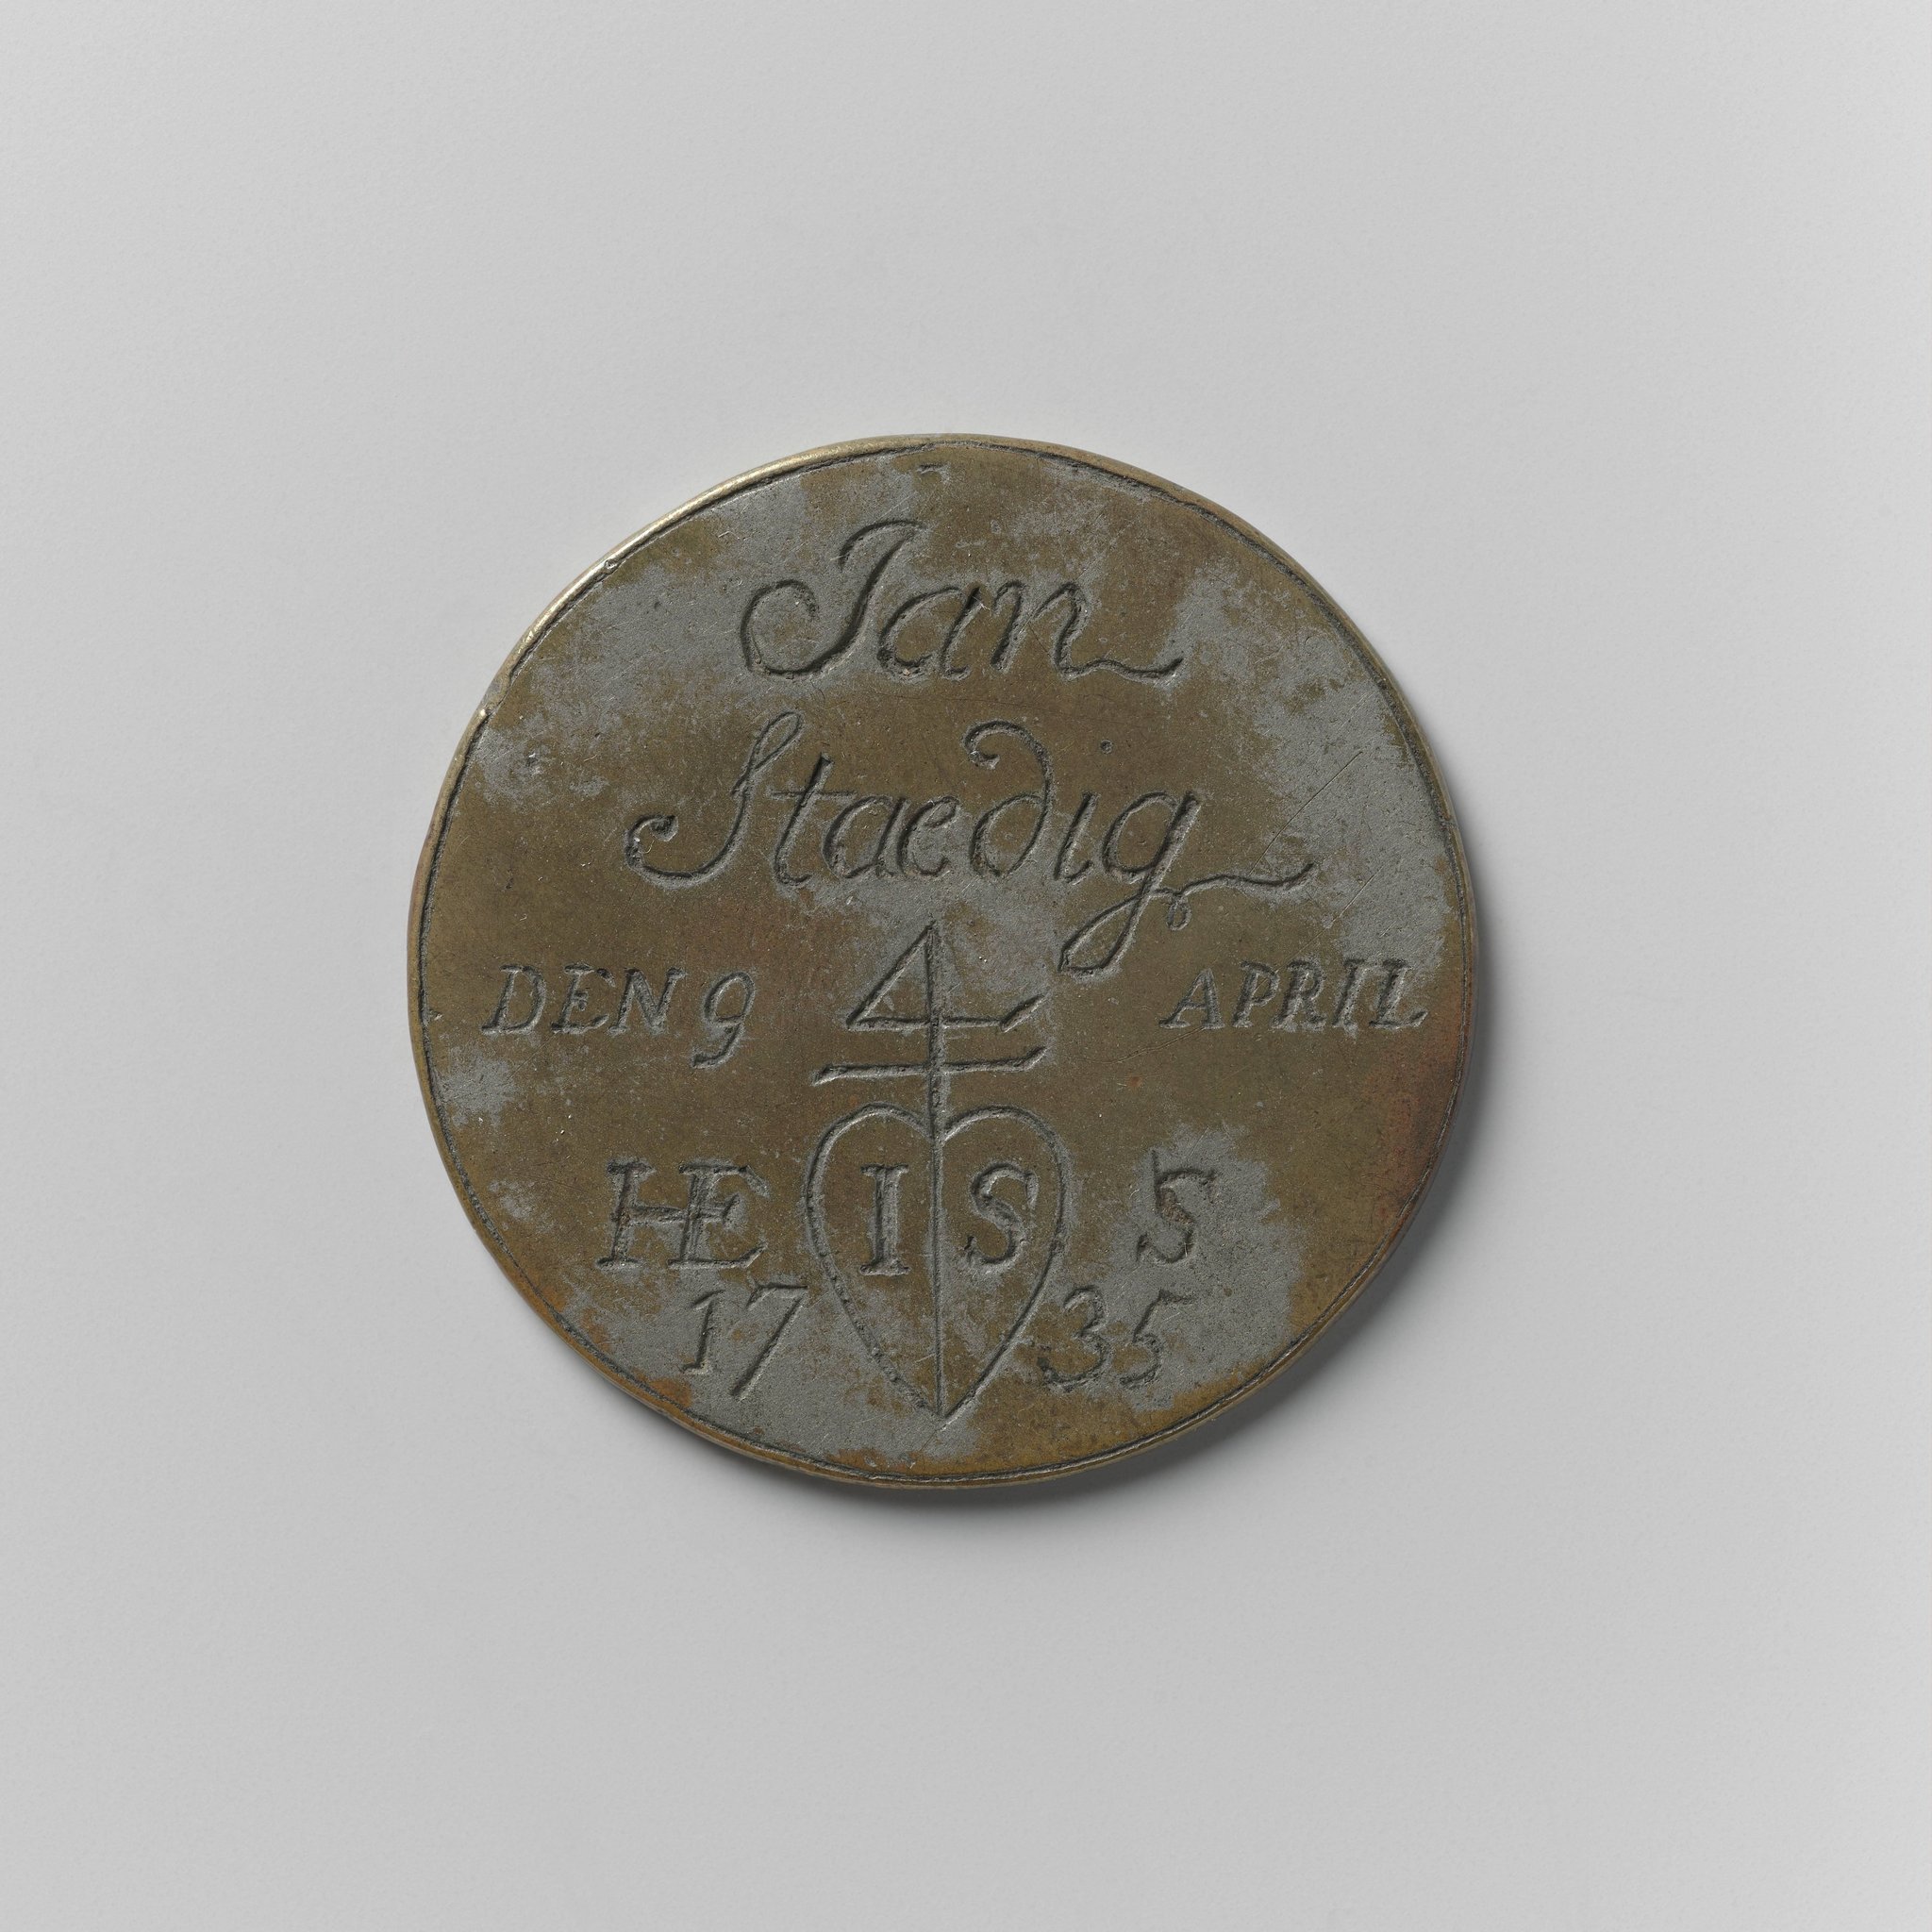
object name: medal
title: Roei-, steiger- en schuitenvoerdersgilde van Amsterdam, gildepenning van Jan Staedig, ligplaats Herbergsteiger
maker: Anonymous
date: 1735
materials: silver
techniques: engraving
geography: amsterdam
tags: amsterdam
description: Zilveren penning. Voorzijde: naar links varende zeilboot; op achterplecht: man en vlag. Keerzijde: opschrift boven huismerk en hart met daarin letters I en S tussen monogram van letters H, E en S en jaartal